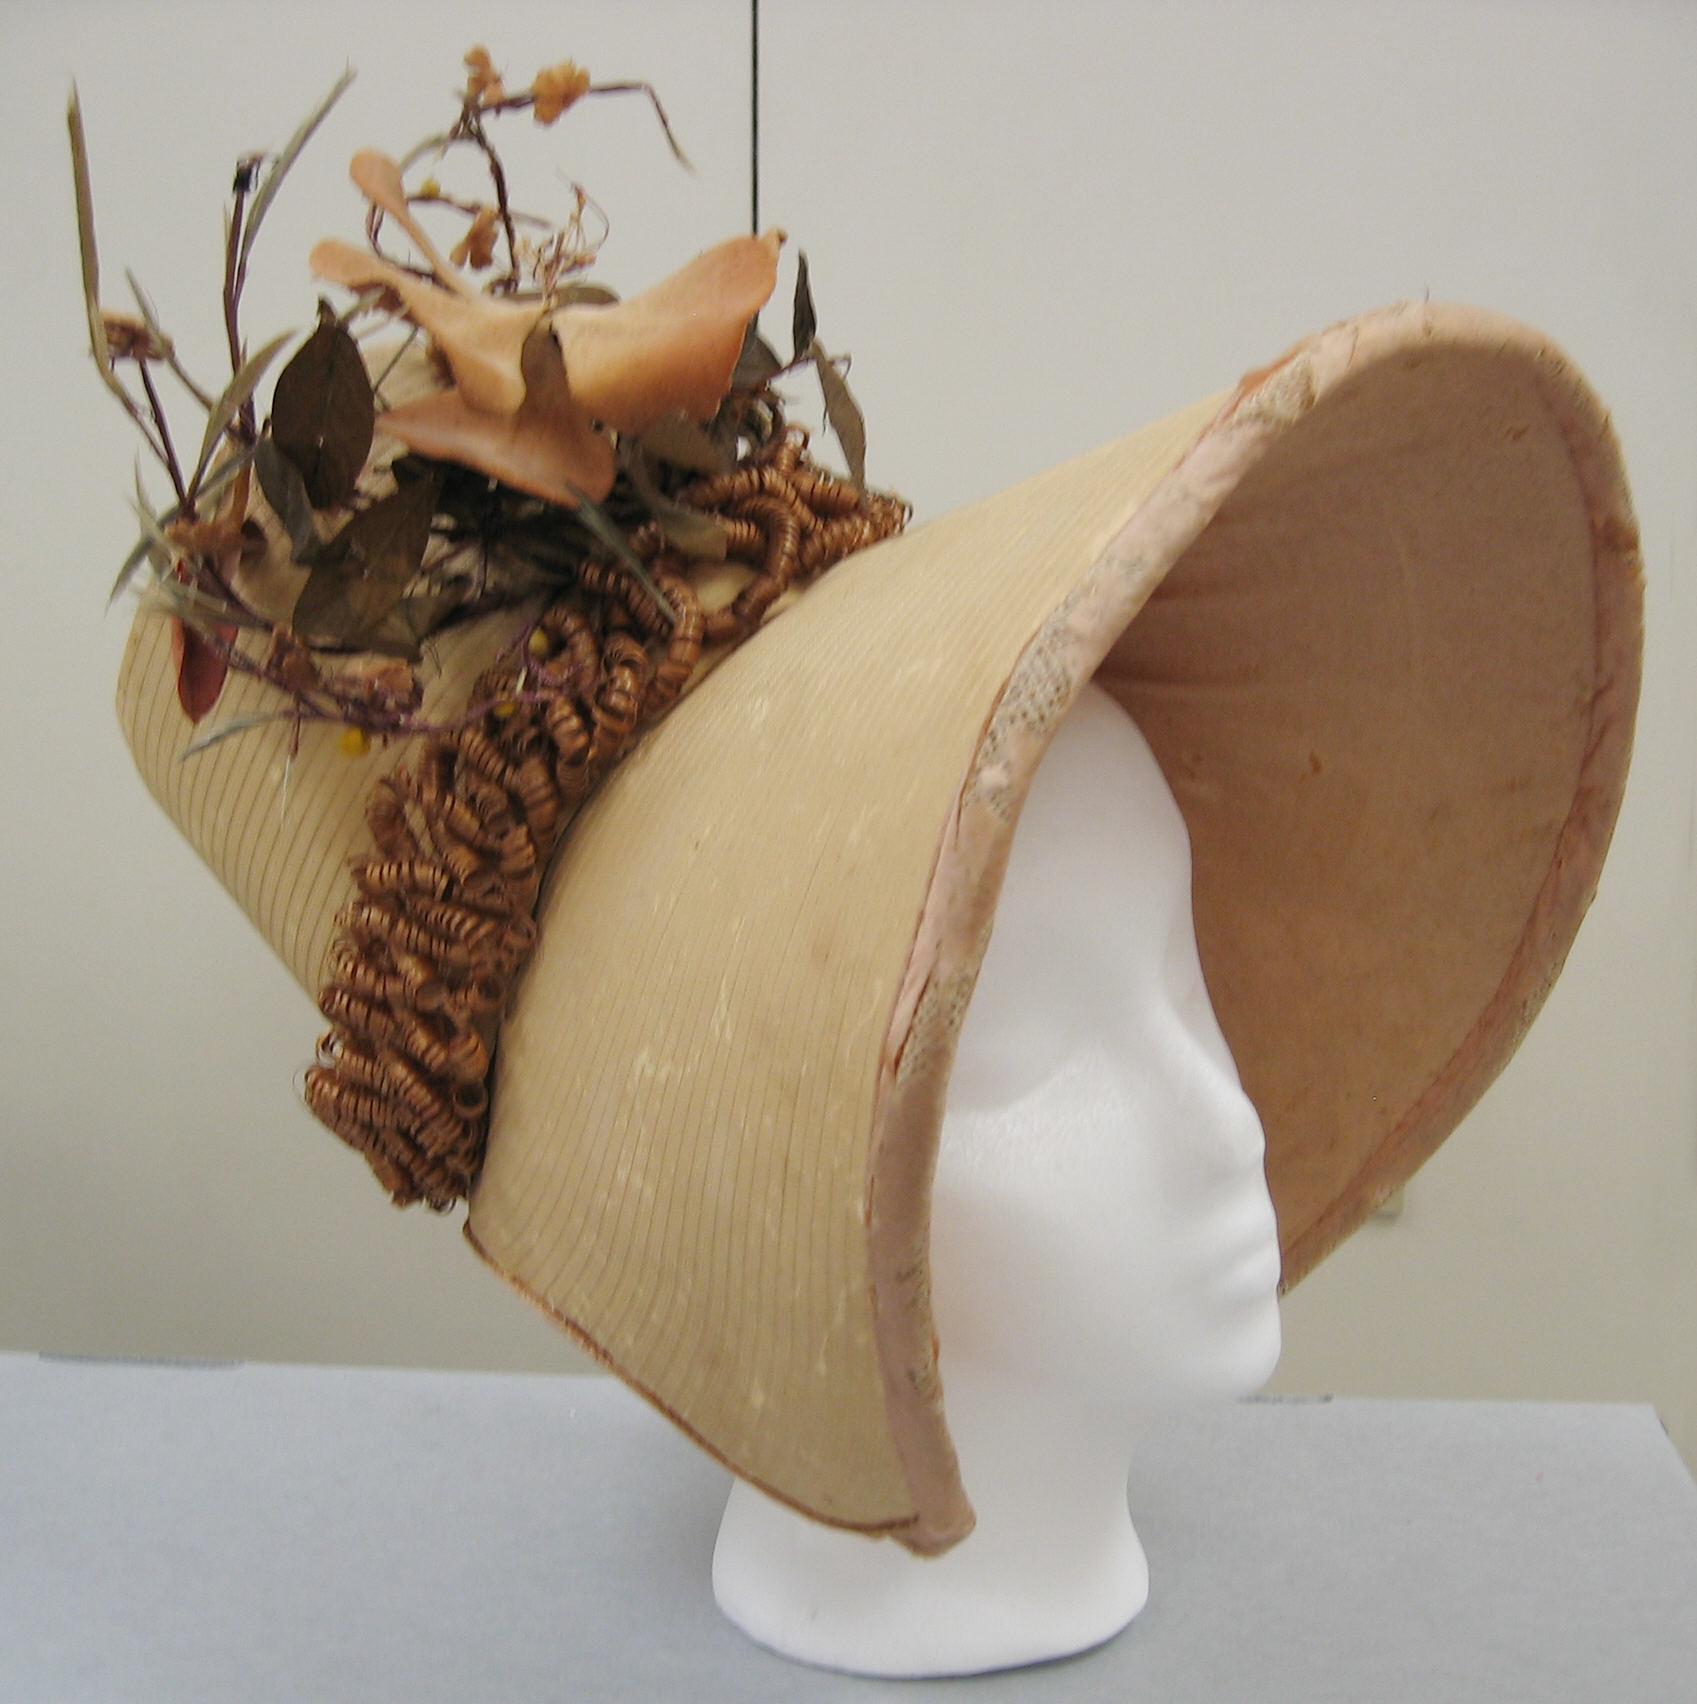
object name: poke bonnet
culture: american or european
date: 1820-1829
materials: paper, silk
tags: plants